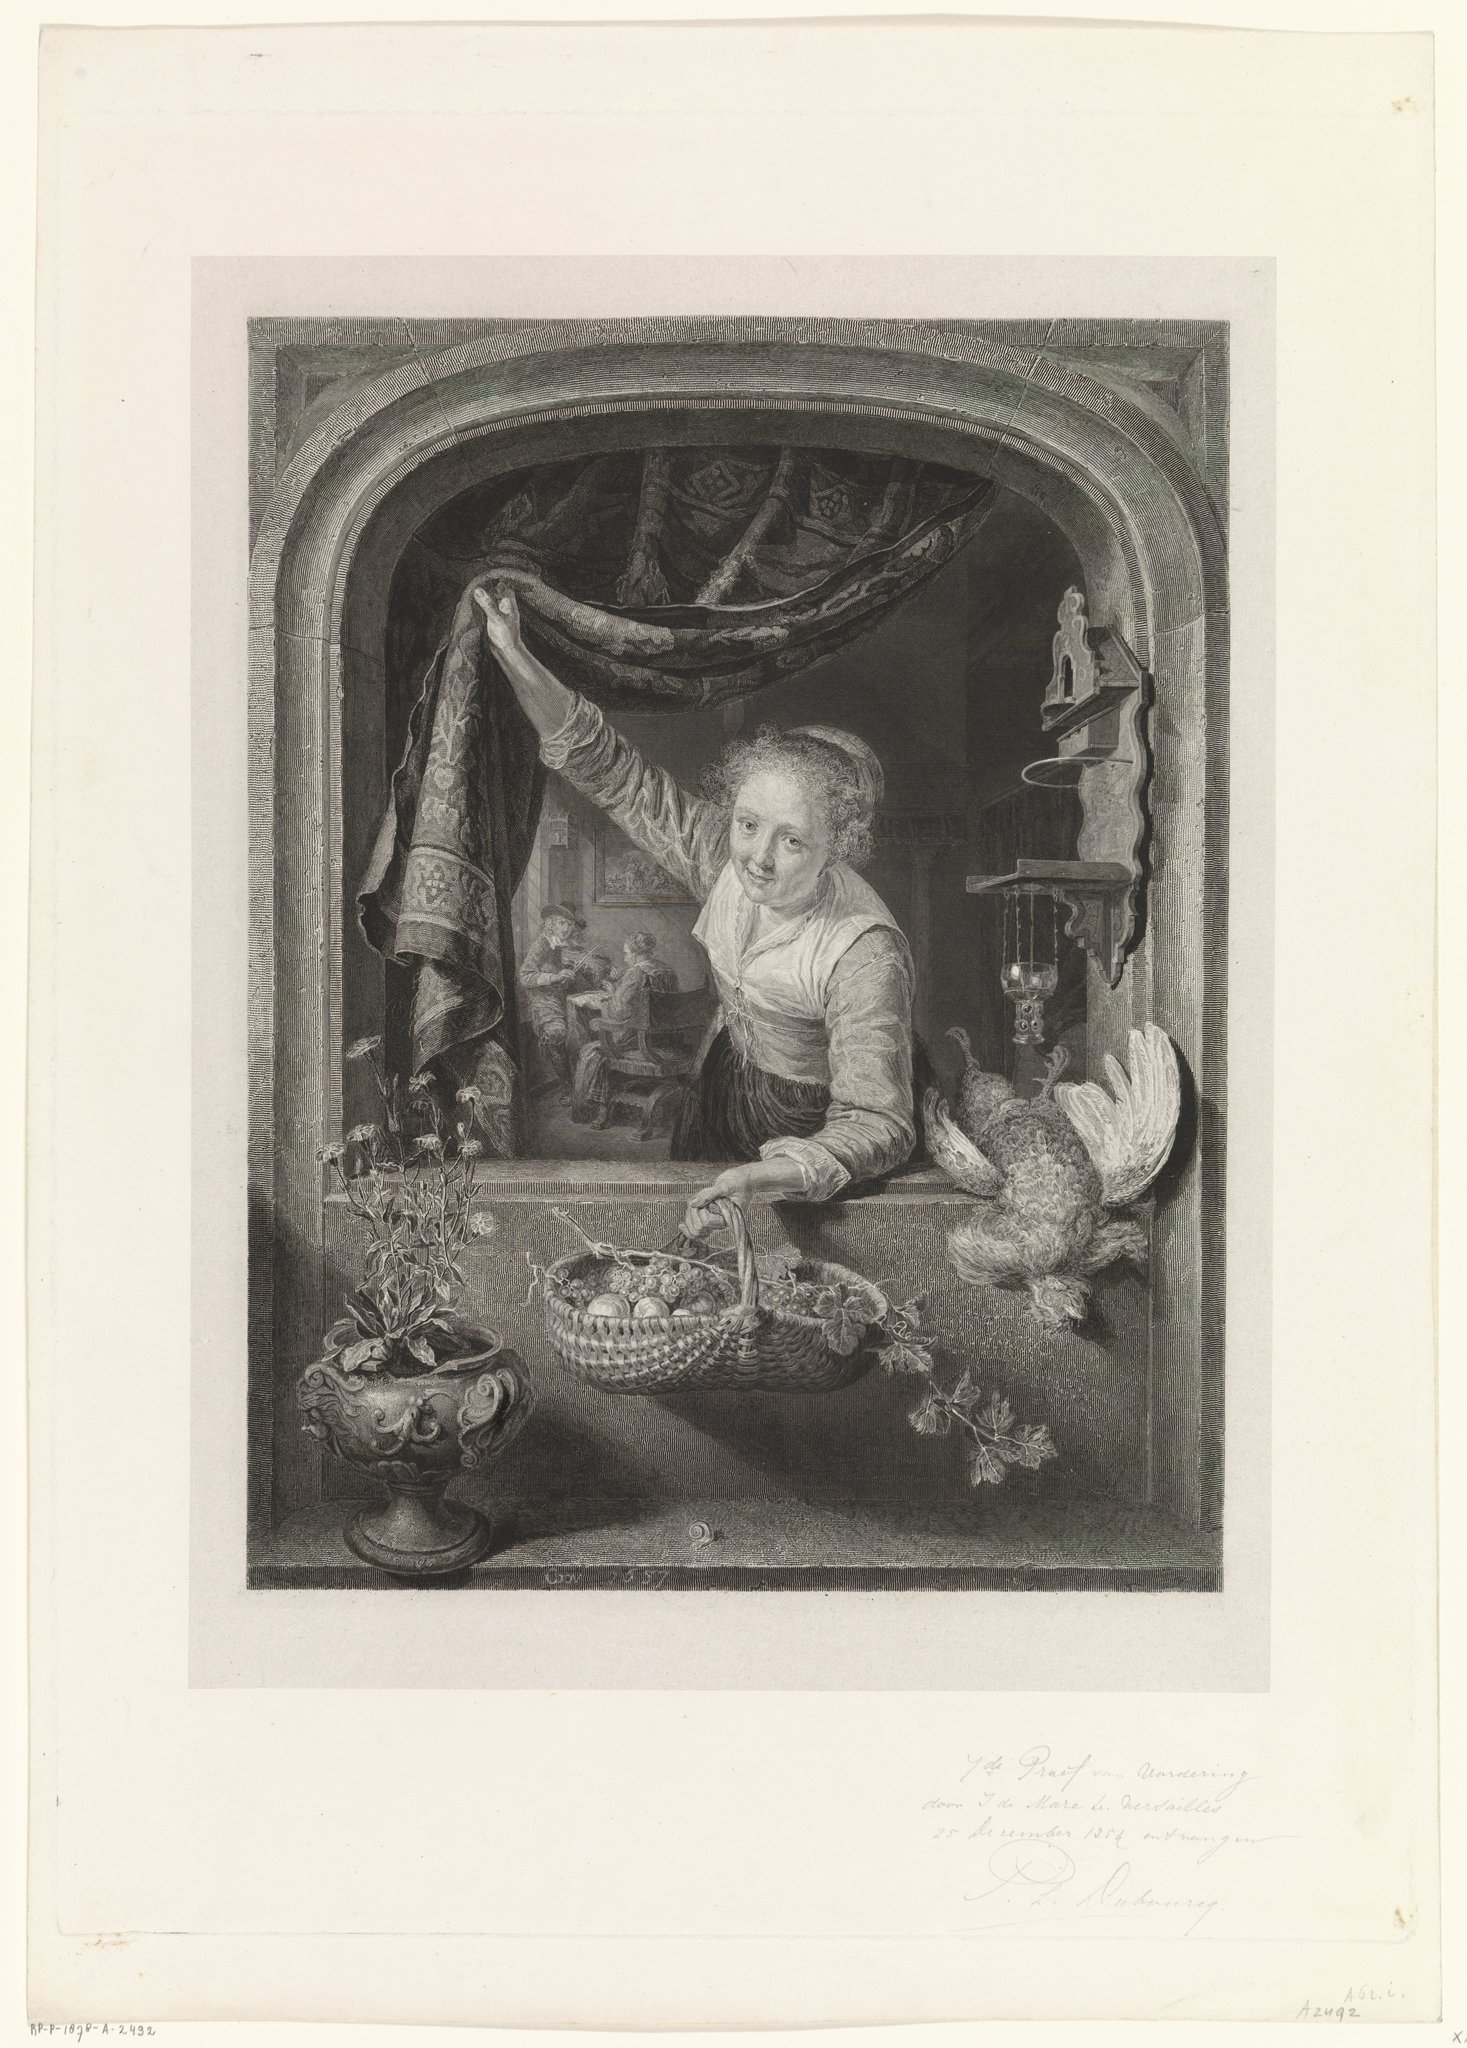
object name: print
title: Vrouw met mand met vruchten in de hand bij het raam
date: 1854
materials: paper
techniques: engraving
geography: versailles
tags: nesting-box, human figure at (open) window, seen from outside, attributes of aesculapius: cock, maid ~ house personnel, one person playing an instrument, shop-window, show-window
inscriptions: inscription: ‘7de Proef van vordering / door J de Mare te Versailles / 25 December 1854 ontvangen / Ph [...]’, collector's mark: Lugt 2228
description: Een jonge vrouw met een mand met vruchten in de hand hangt uit een venster. Ze houdt het gordijn opzij zodat het interieur achter haar zichtbaar is. In het vertrek zijn een man en een vrouw aan het musiceren. In de vensterbank hangt een vogelhuis, ligt een dode haan en staat een vaas met bloemen.